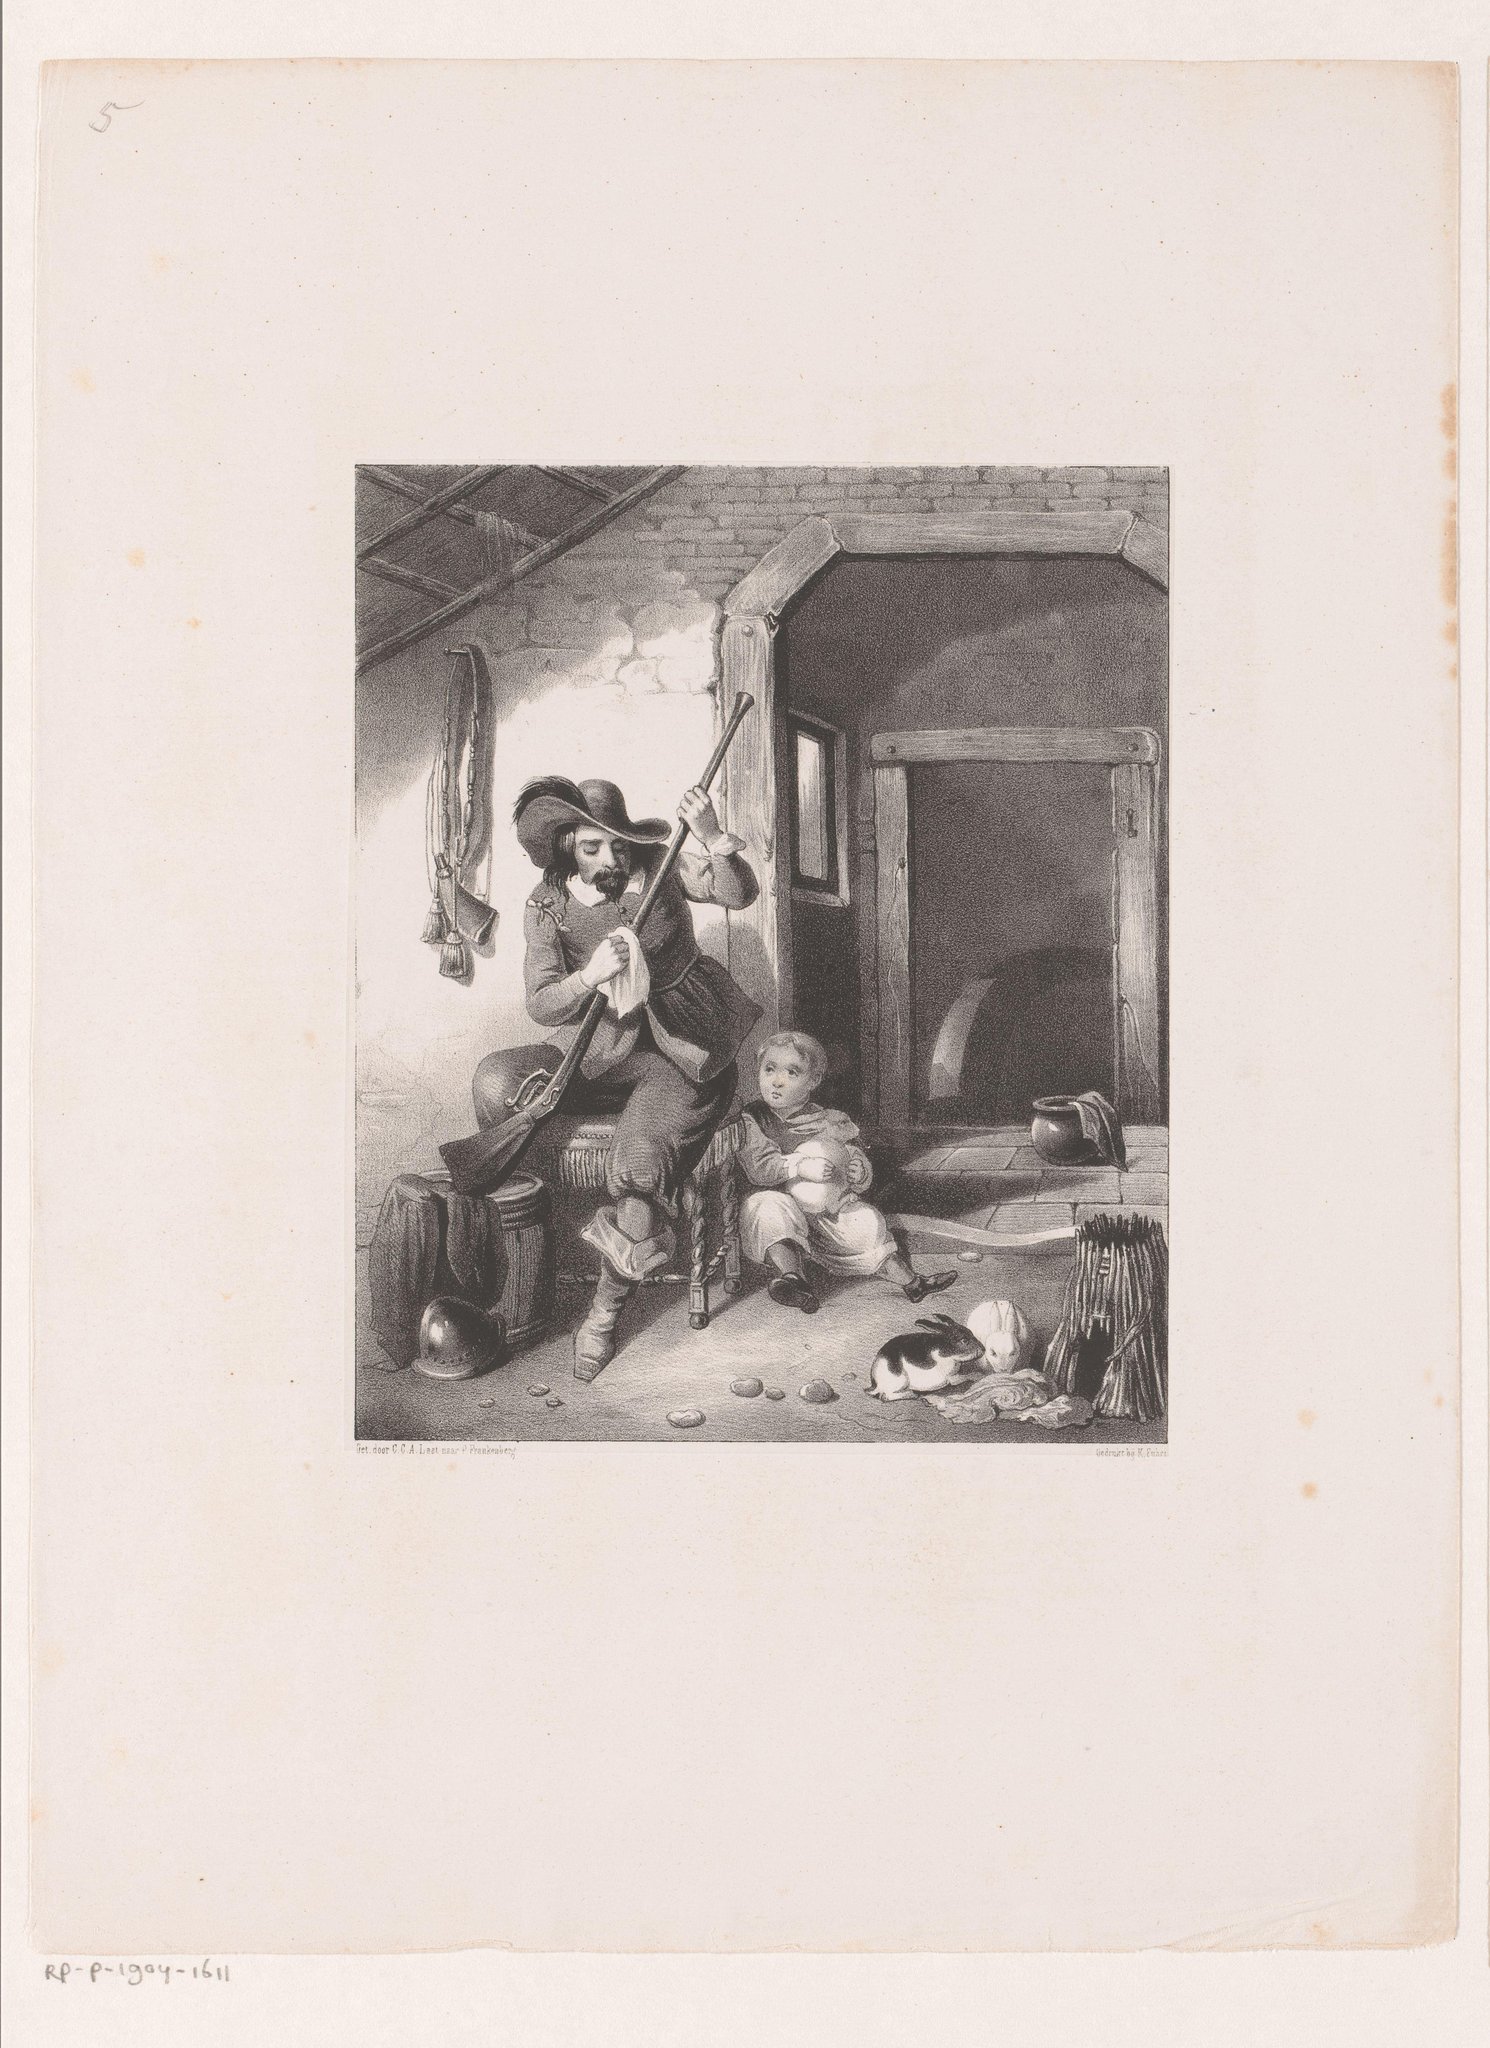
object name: print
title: Soldaat maakt zijn geweer schoon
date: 1837-1853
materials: paper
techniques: lithograph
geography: the hague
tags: child, firearms: rifle, the soldier; the soldier's life, rodents: rabbit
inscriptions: collector's mark: Lugt 2228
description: Achter hem zit een kind met een konijn op schoot.